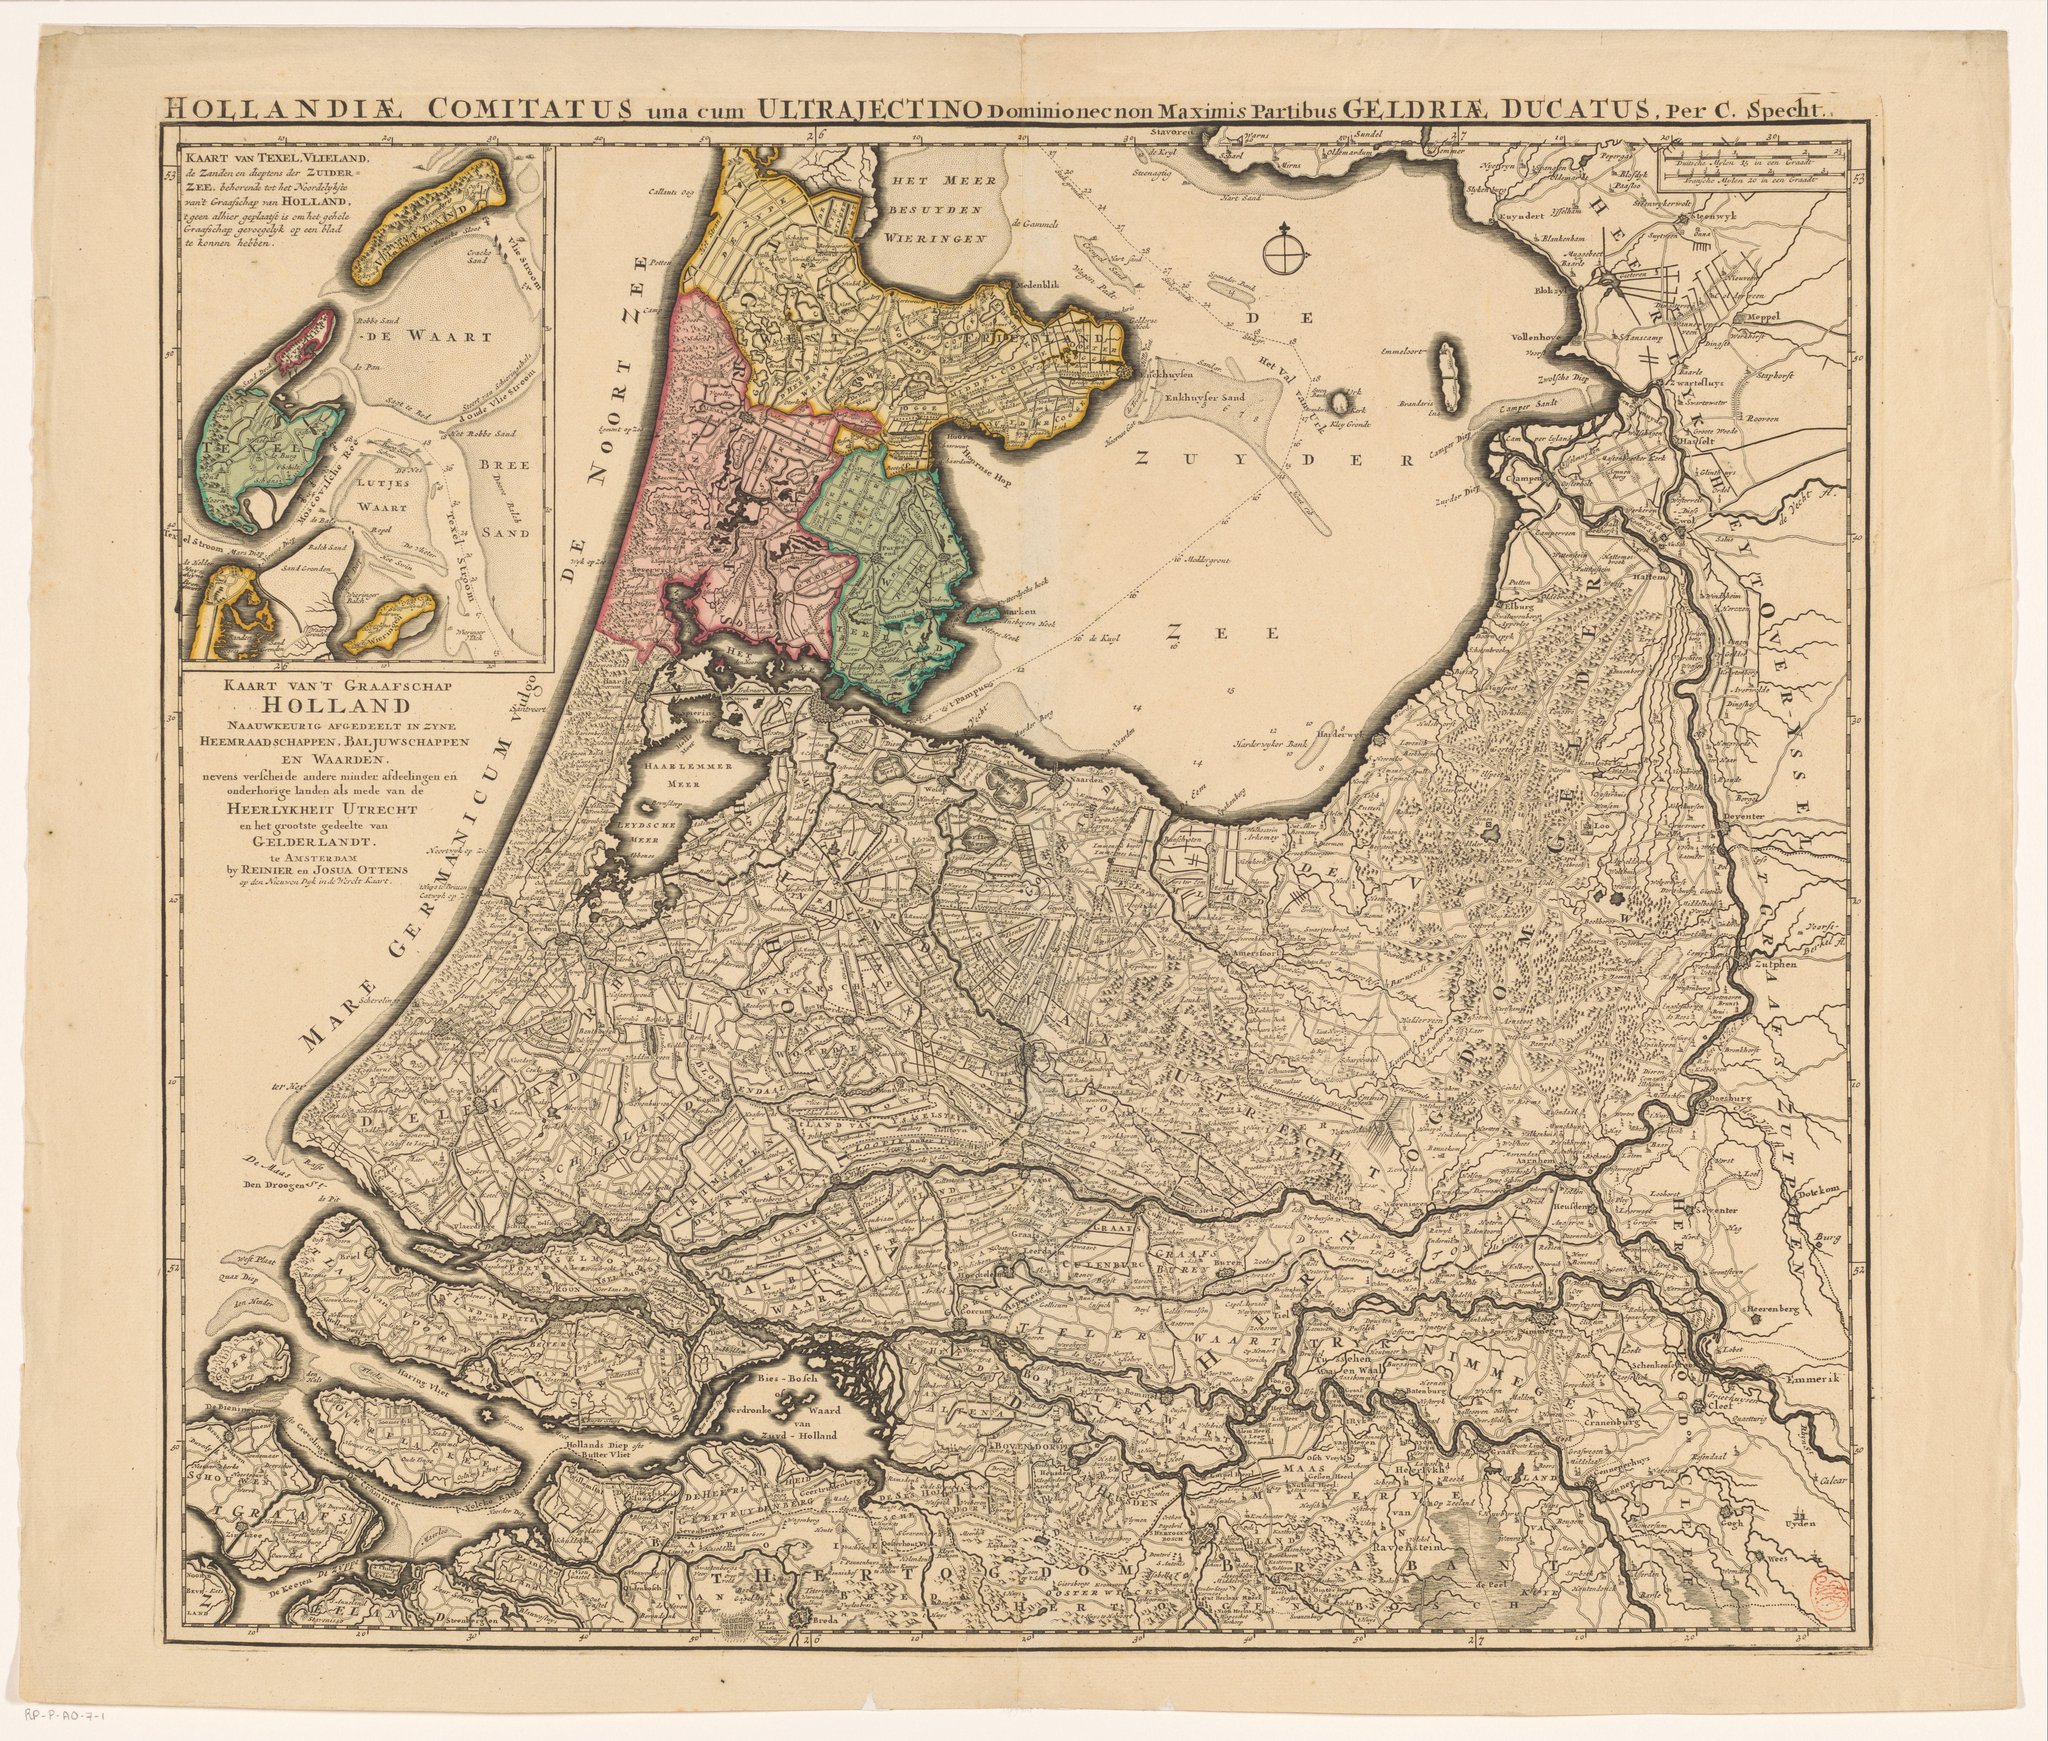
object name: print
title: Kaart van Holland, Utrecht en een deel van Gelderland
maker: caspar specht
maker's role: print maker, publisher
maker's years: 1654-1710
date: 1704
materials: paper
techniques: engraving, hand coloring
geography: utrecht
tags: maps of separate countries or regions, gelderland, holland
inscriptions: collector's mark: Lugt 195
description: Kaart van het graafschap Holland, de heerlijkheid Utrecht en het grootste deel van het hertogdom Gelderland. Linksboven een inzetkaart van Texel en Vlieland. Daaronder de Nederlandse titel. Rechtsboven twee schaalstokken: Duitsche mylen 15 in een graadt; Fransche mylen 20 in een graadt. Gradenverdeling langs de randen.